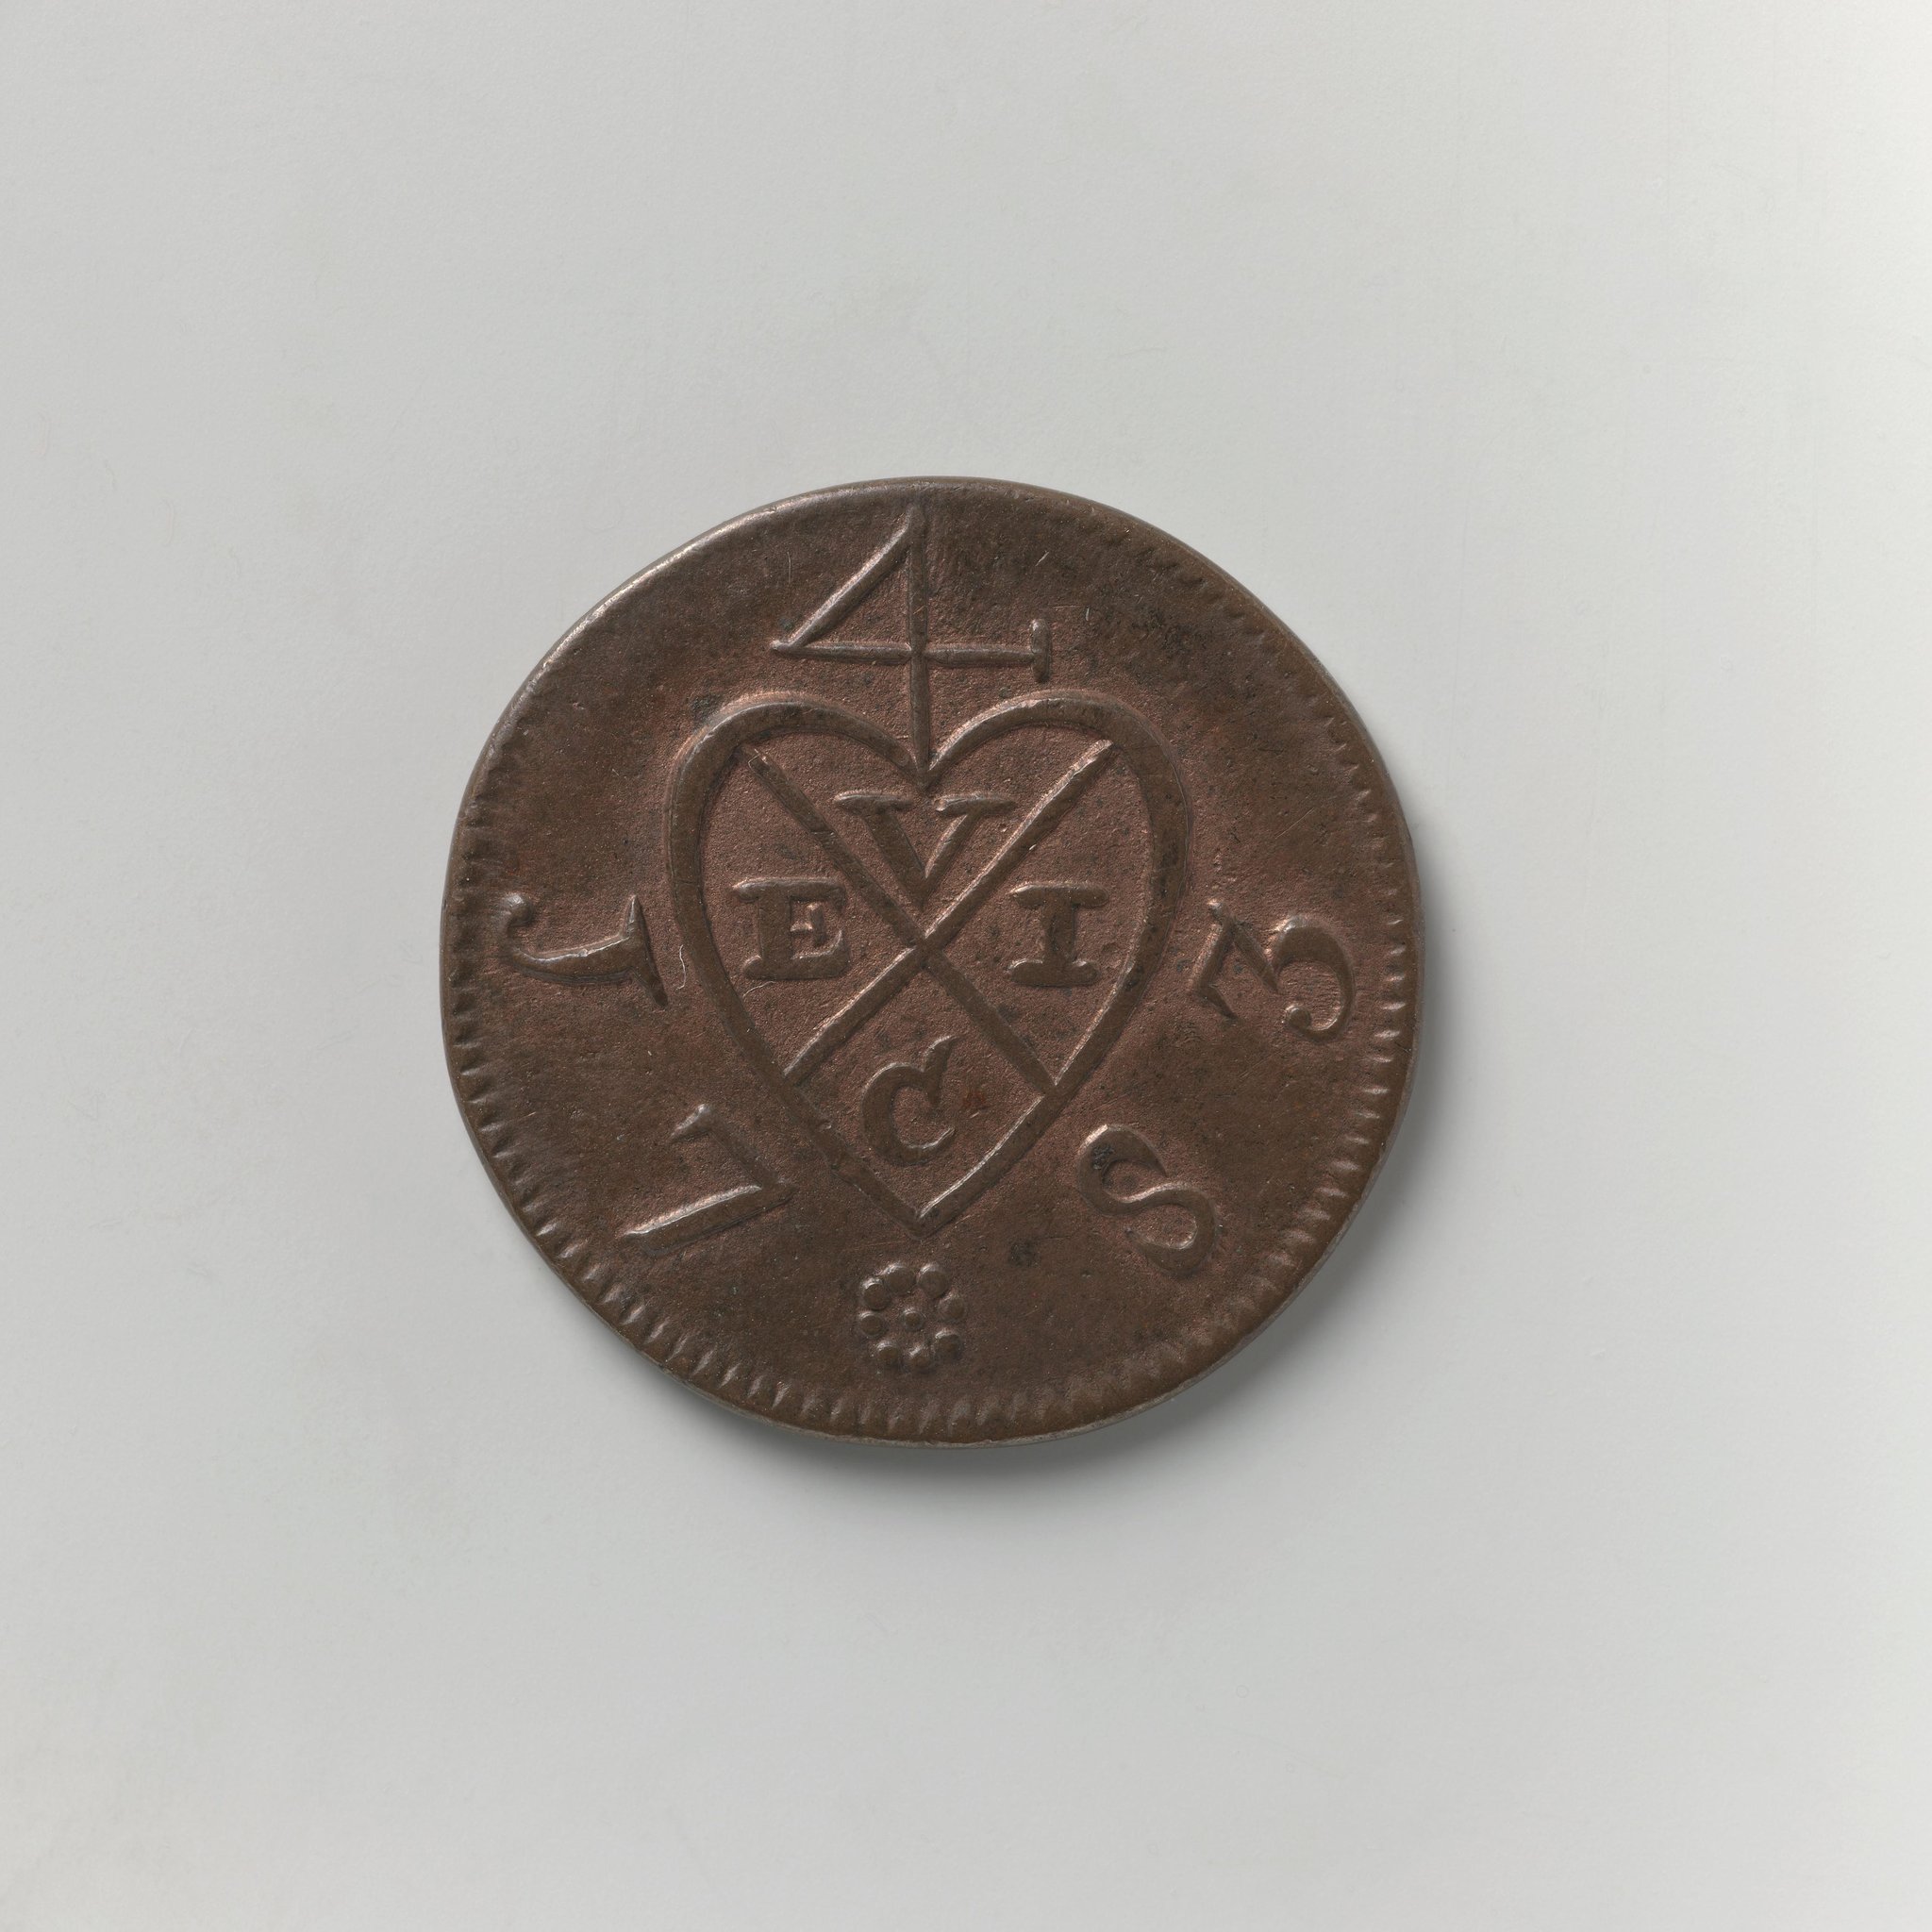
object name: coin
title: 2 kepengs van Engels Sumatra, Benkoelen,1783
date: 1783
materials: copper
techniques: striking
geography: kolkata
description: Koperen munt. Voorzijde: monogram van de Engelse Oostindische Compagnie, waaromheen jaartal. Keerzijde: op een regel in het Maleis waarde-aanduiding: doewa kepeng in Arabische lettertekens, waarboven waarde-aanduiding: 2 met Arabisch cijfer en waaronder jaartal in Islamitische tijdsrekening en Arabische cijfers. Gladde rand.